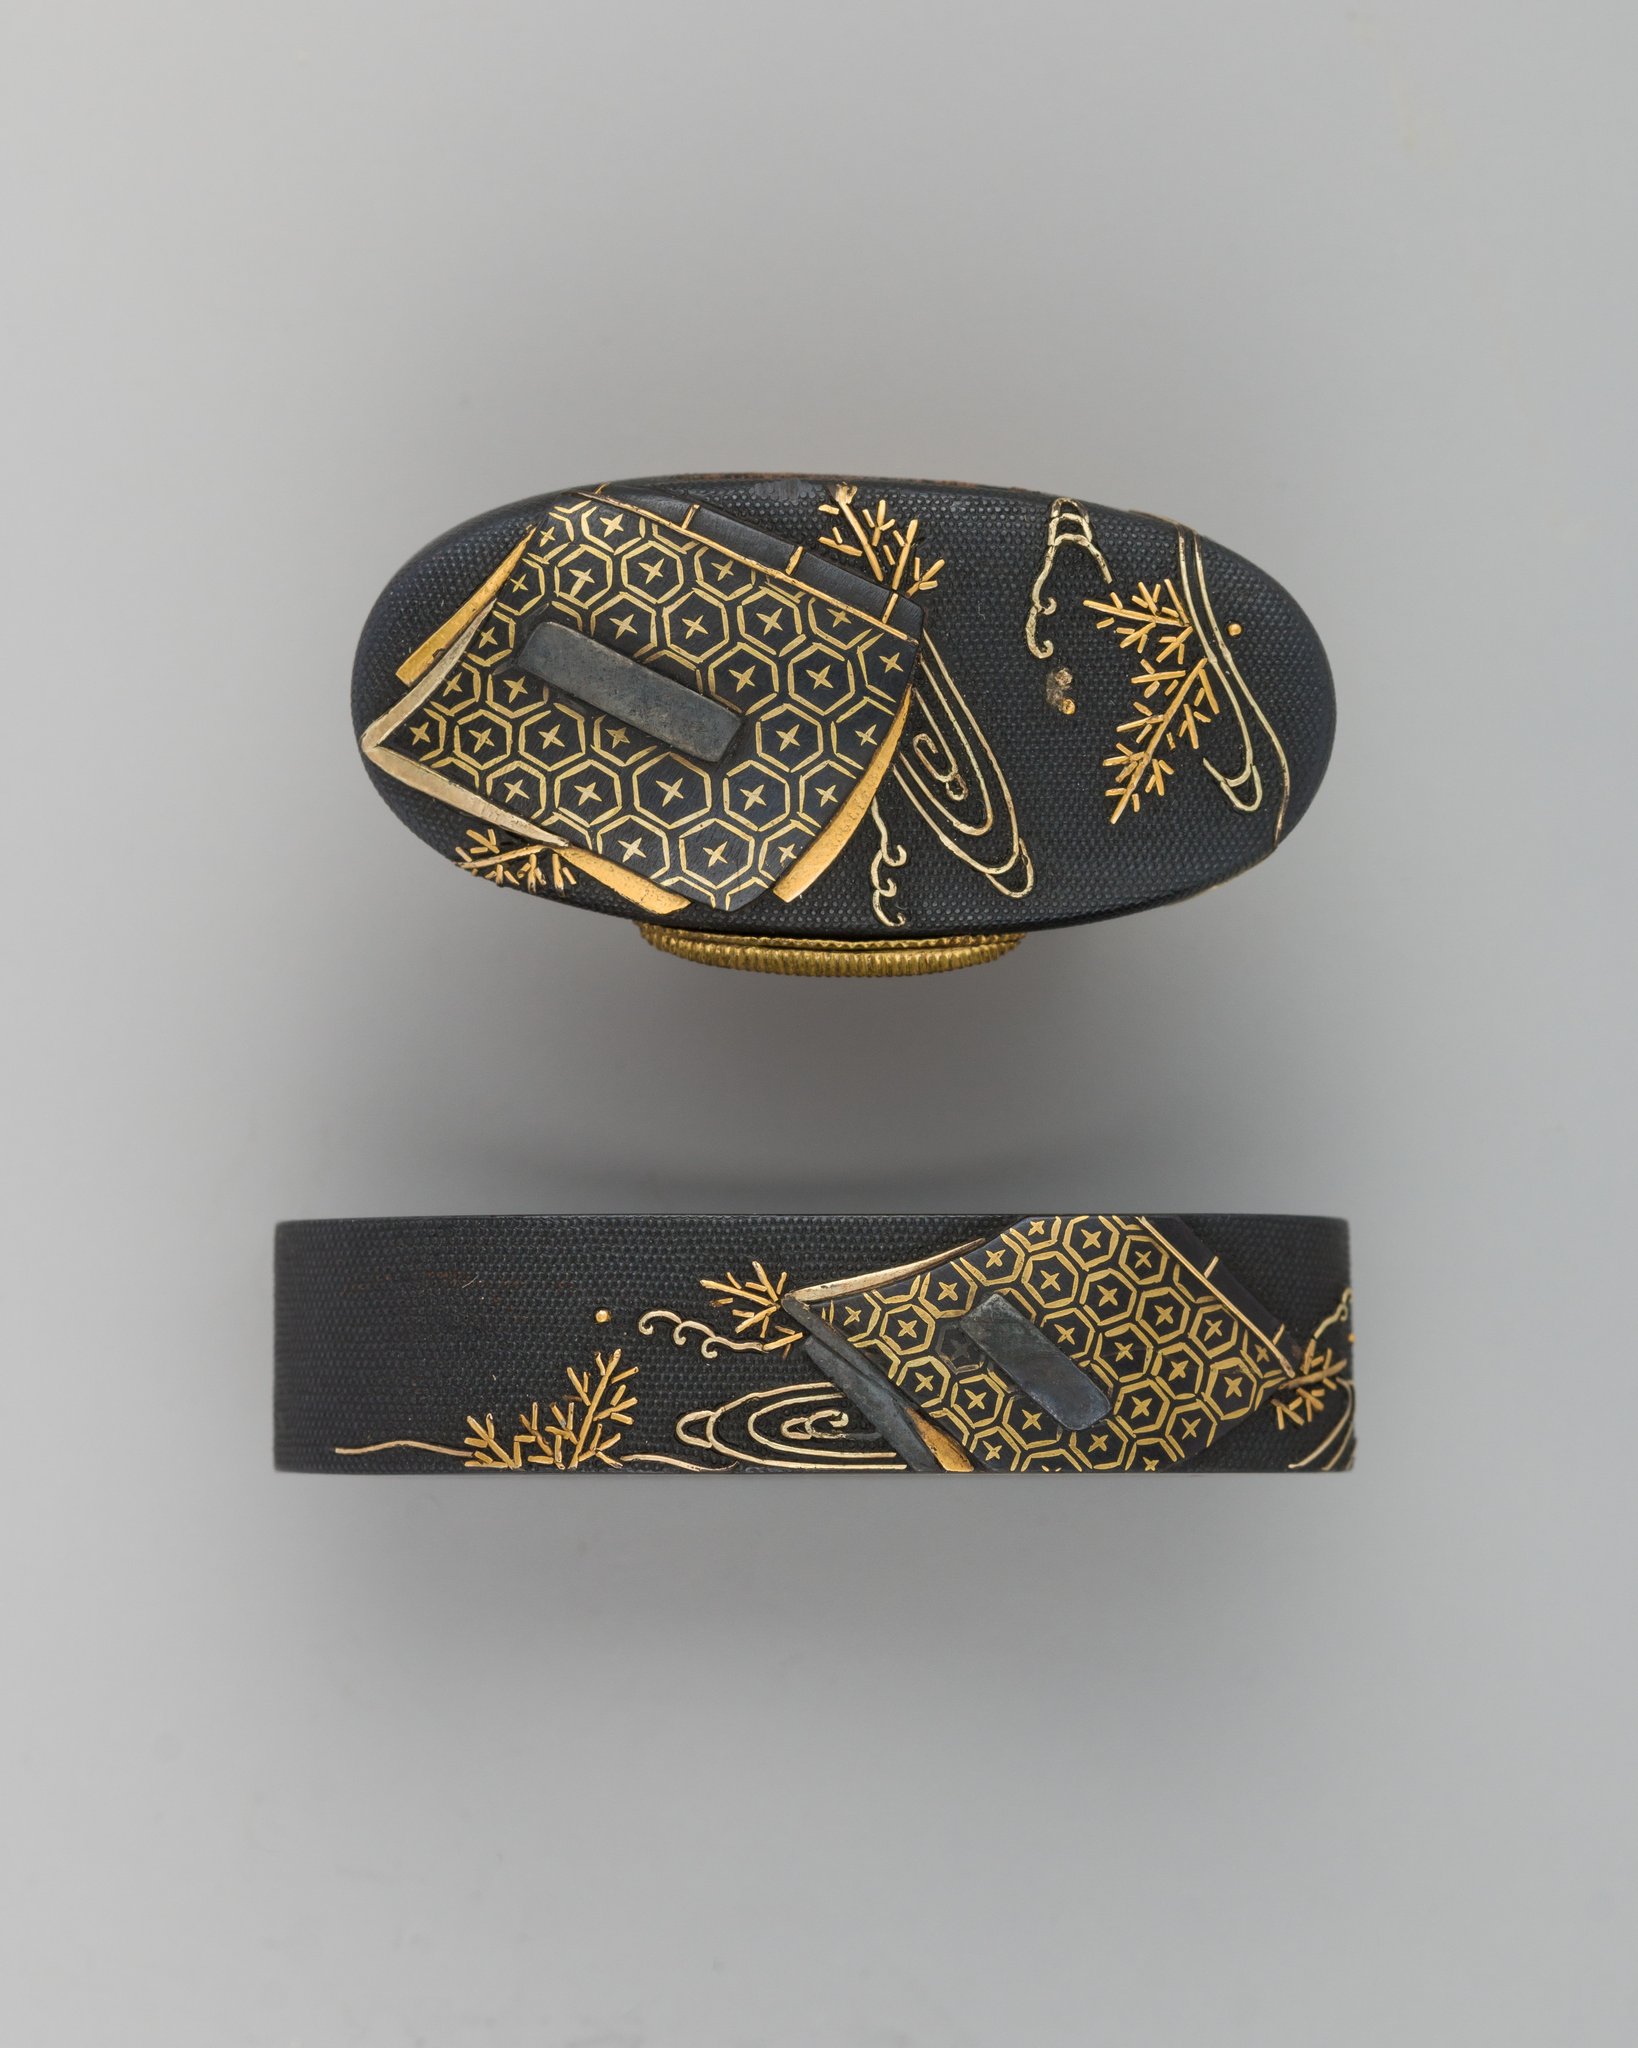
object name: sword hilt collar and pommel fuchigashira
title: Sword-Hilt Collar and Pommel (Fuchigashira)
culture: japanese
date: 1615-1868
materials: gold alloy, gold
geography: japan